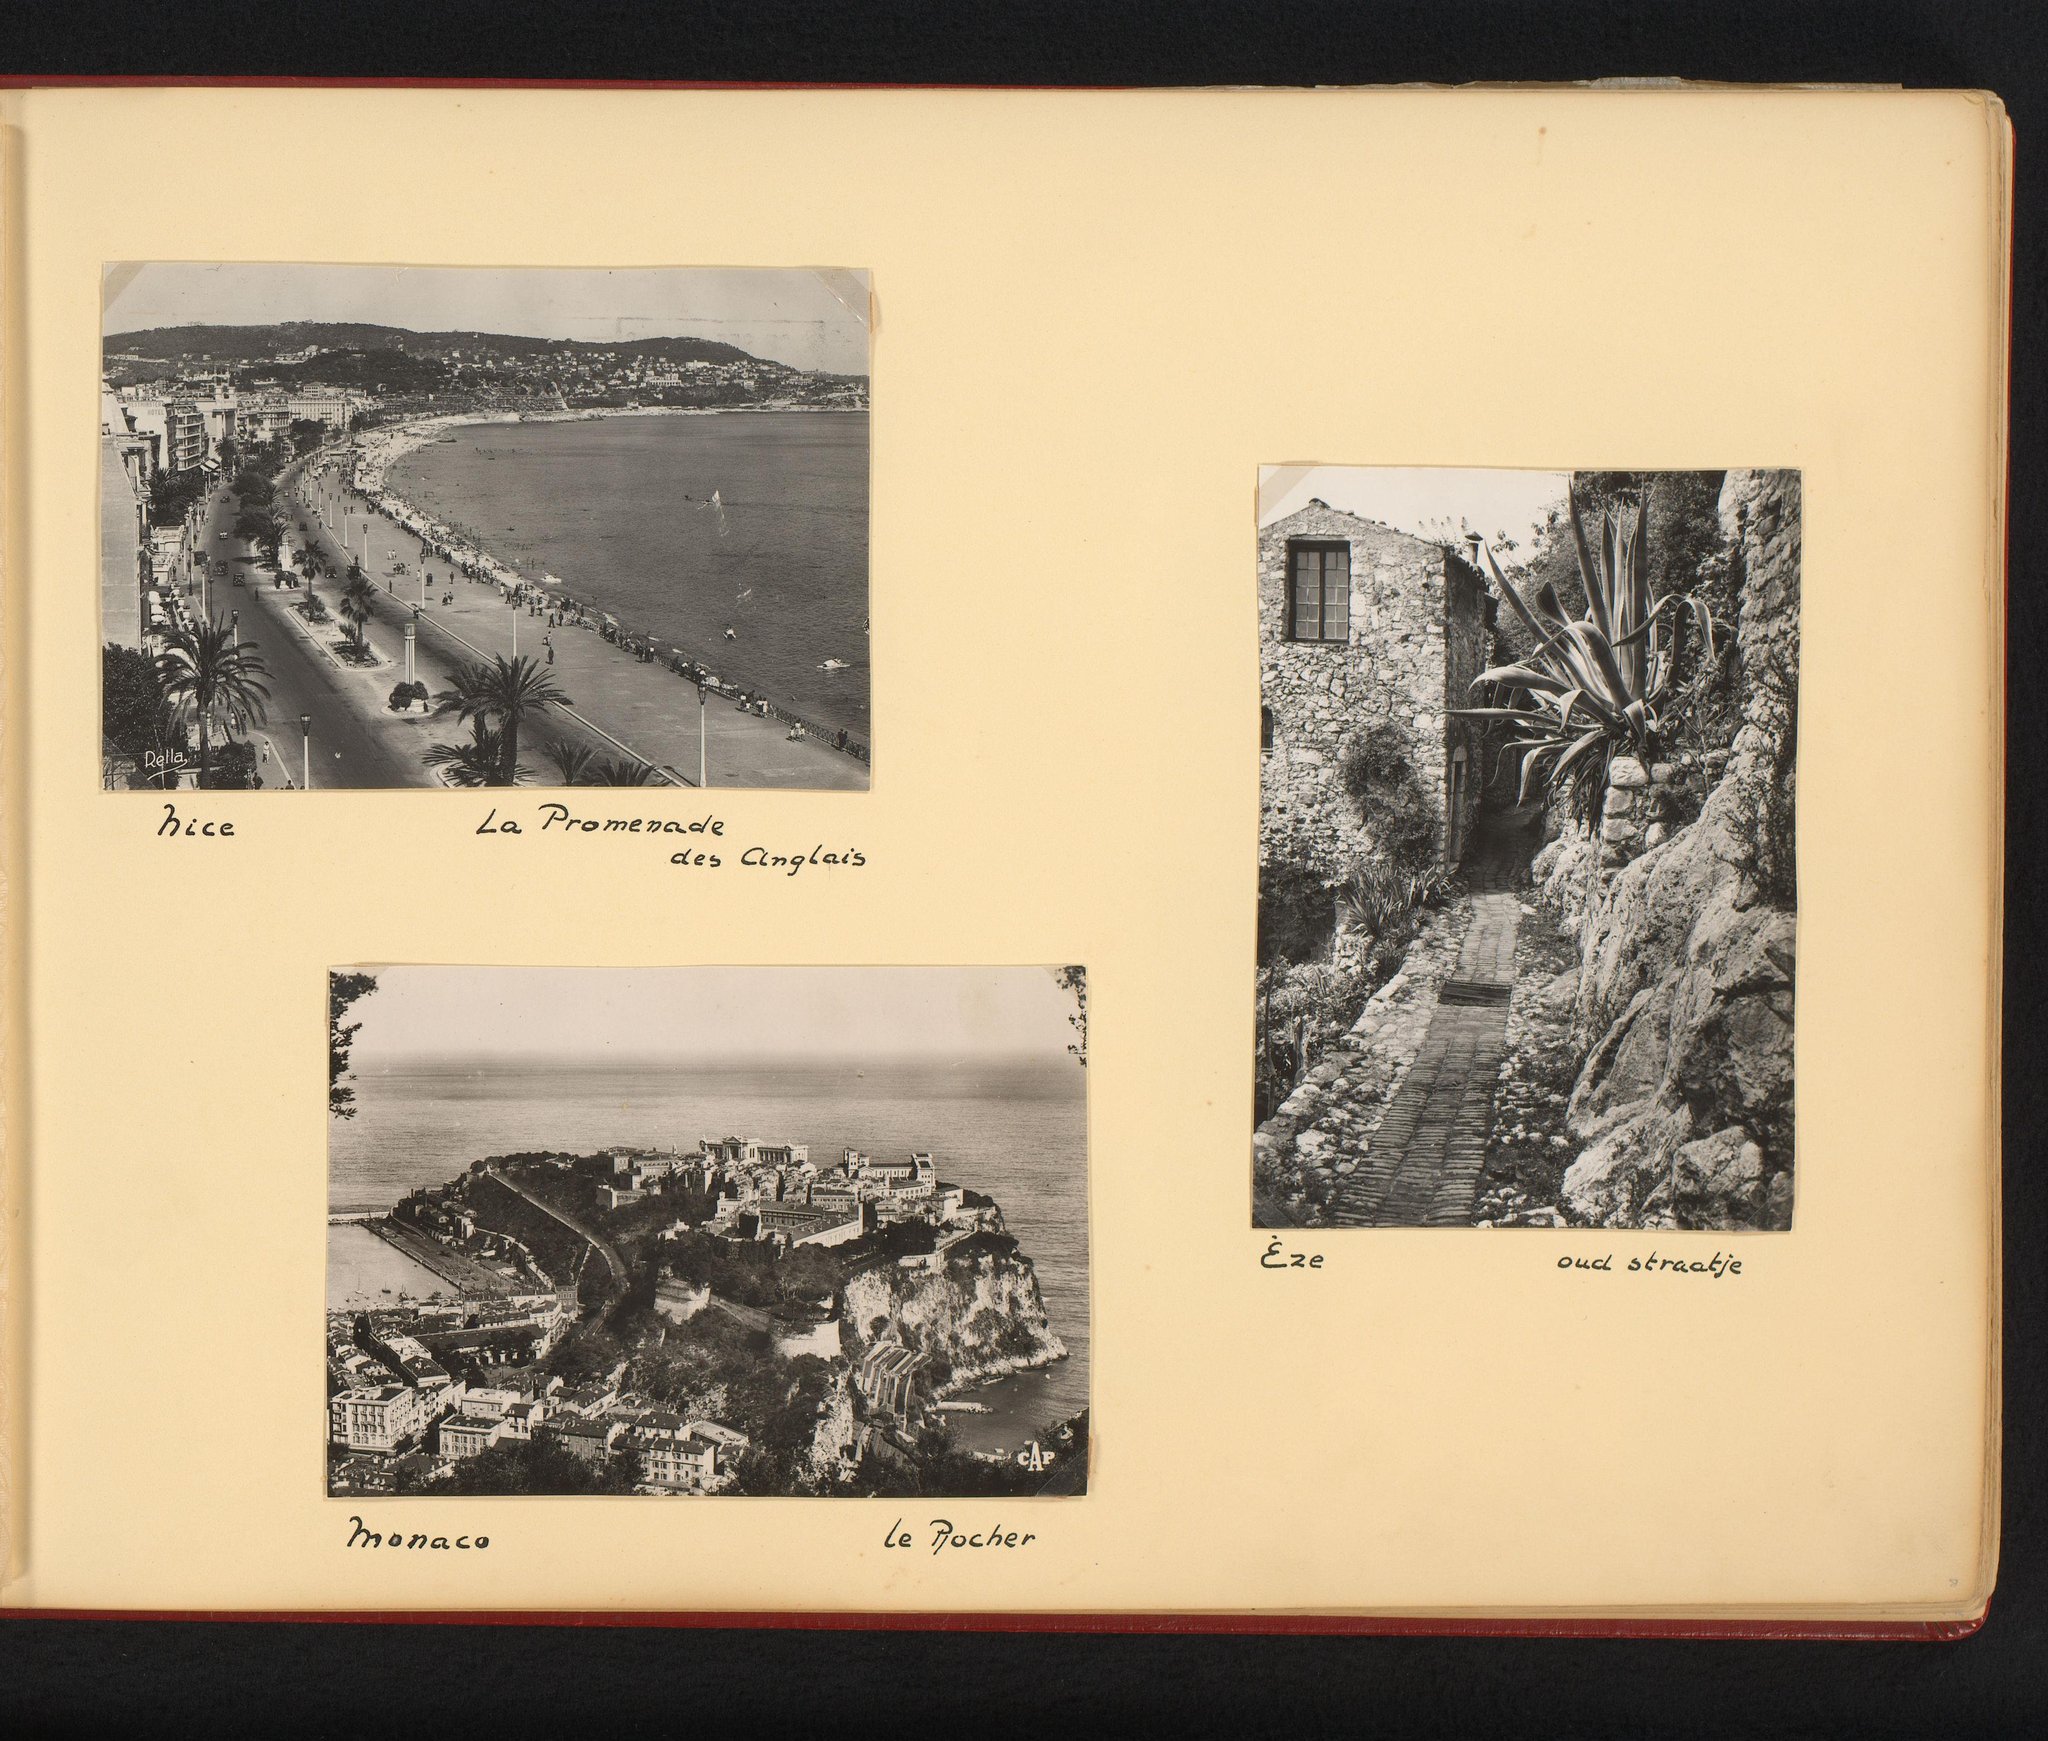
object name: album leaf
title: Nice, Èze en Monaco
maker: Anonymous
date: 1951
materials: paper, photographic support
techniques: gelatin silver print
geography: france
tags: the family travelling, on holiday, outing, pleasure trip, france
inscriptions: inscription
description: Albumblad met drie prentbriefkaarten van Nice, Èze en Monaco. Herinnering aan een vakantiereis door Frankrijk van 23 augustus tot 9 september 1951. Onderdeel van het fotoalbum 'Met de Fiat 500 cabriolet op vakantie' met foto's van vakanties van een gezin tussen 1951-1959.